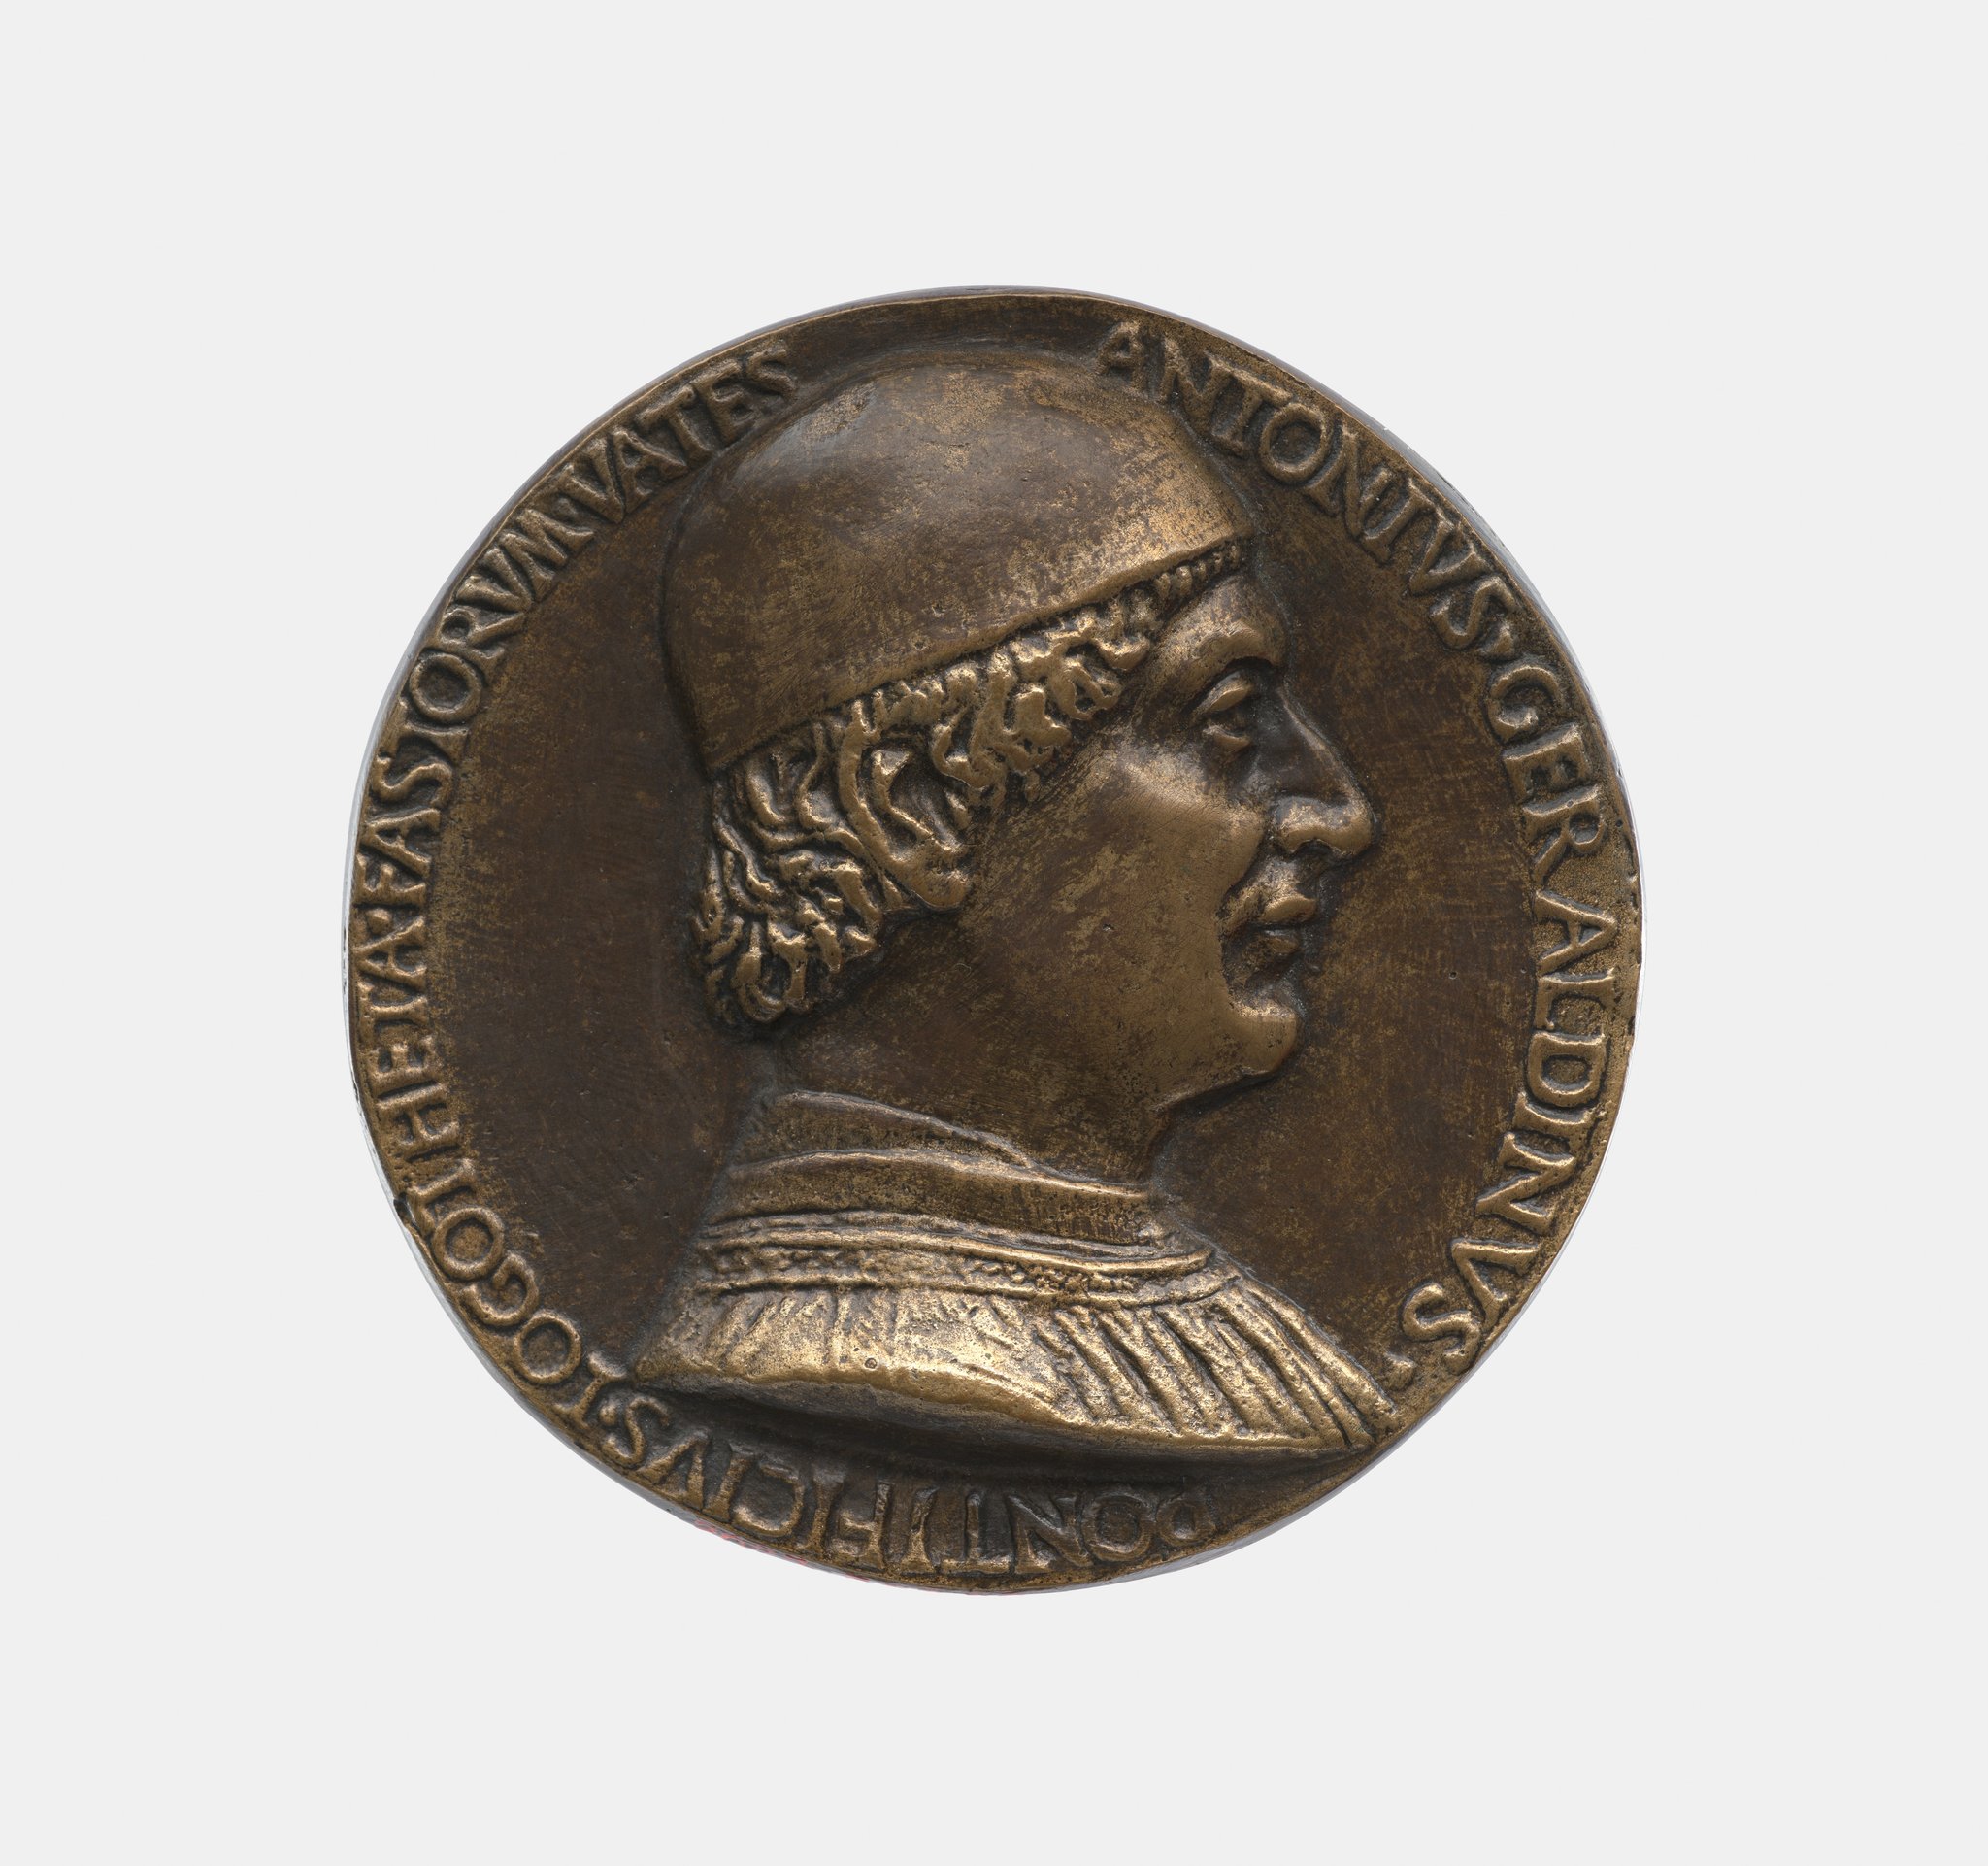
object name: medal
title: Antonio Geraldini 1449?–1489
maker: niccolò fiorentino (niccolò di forzore spinelli)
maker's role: artist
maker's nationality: italian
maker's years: 1430-1514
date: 1467-1500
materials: bronze